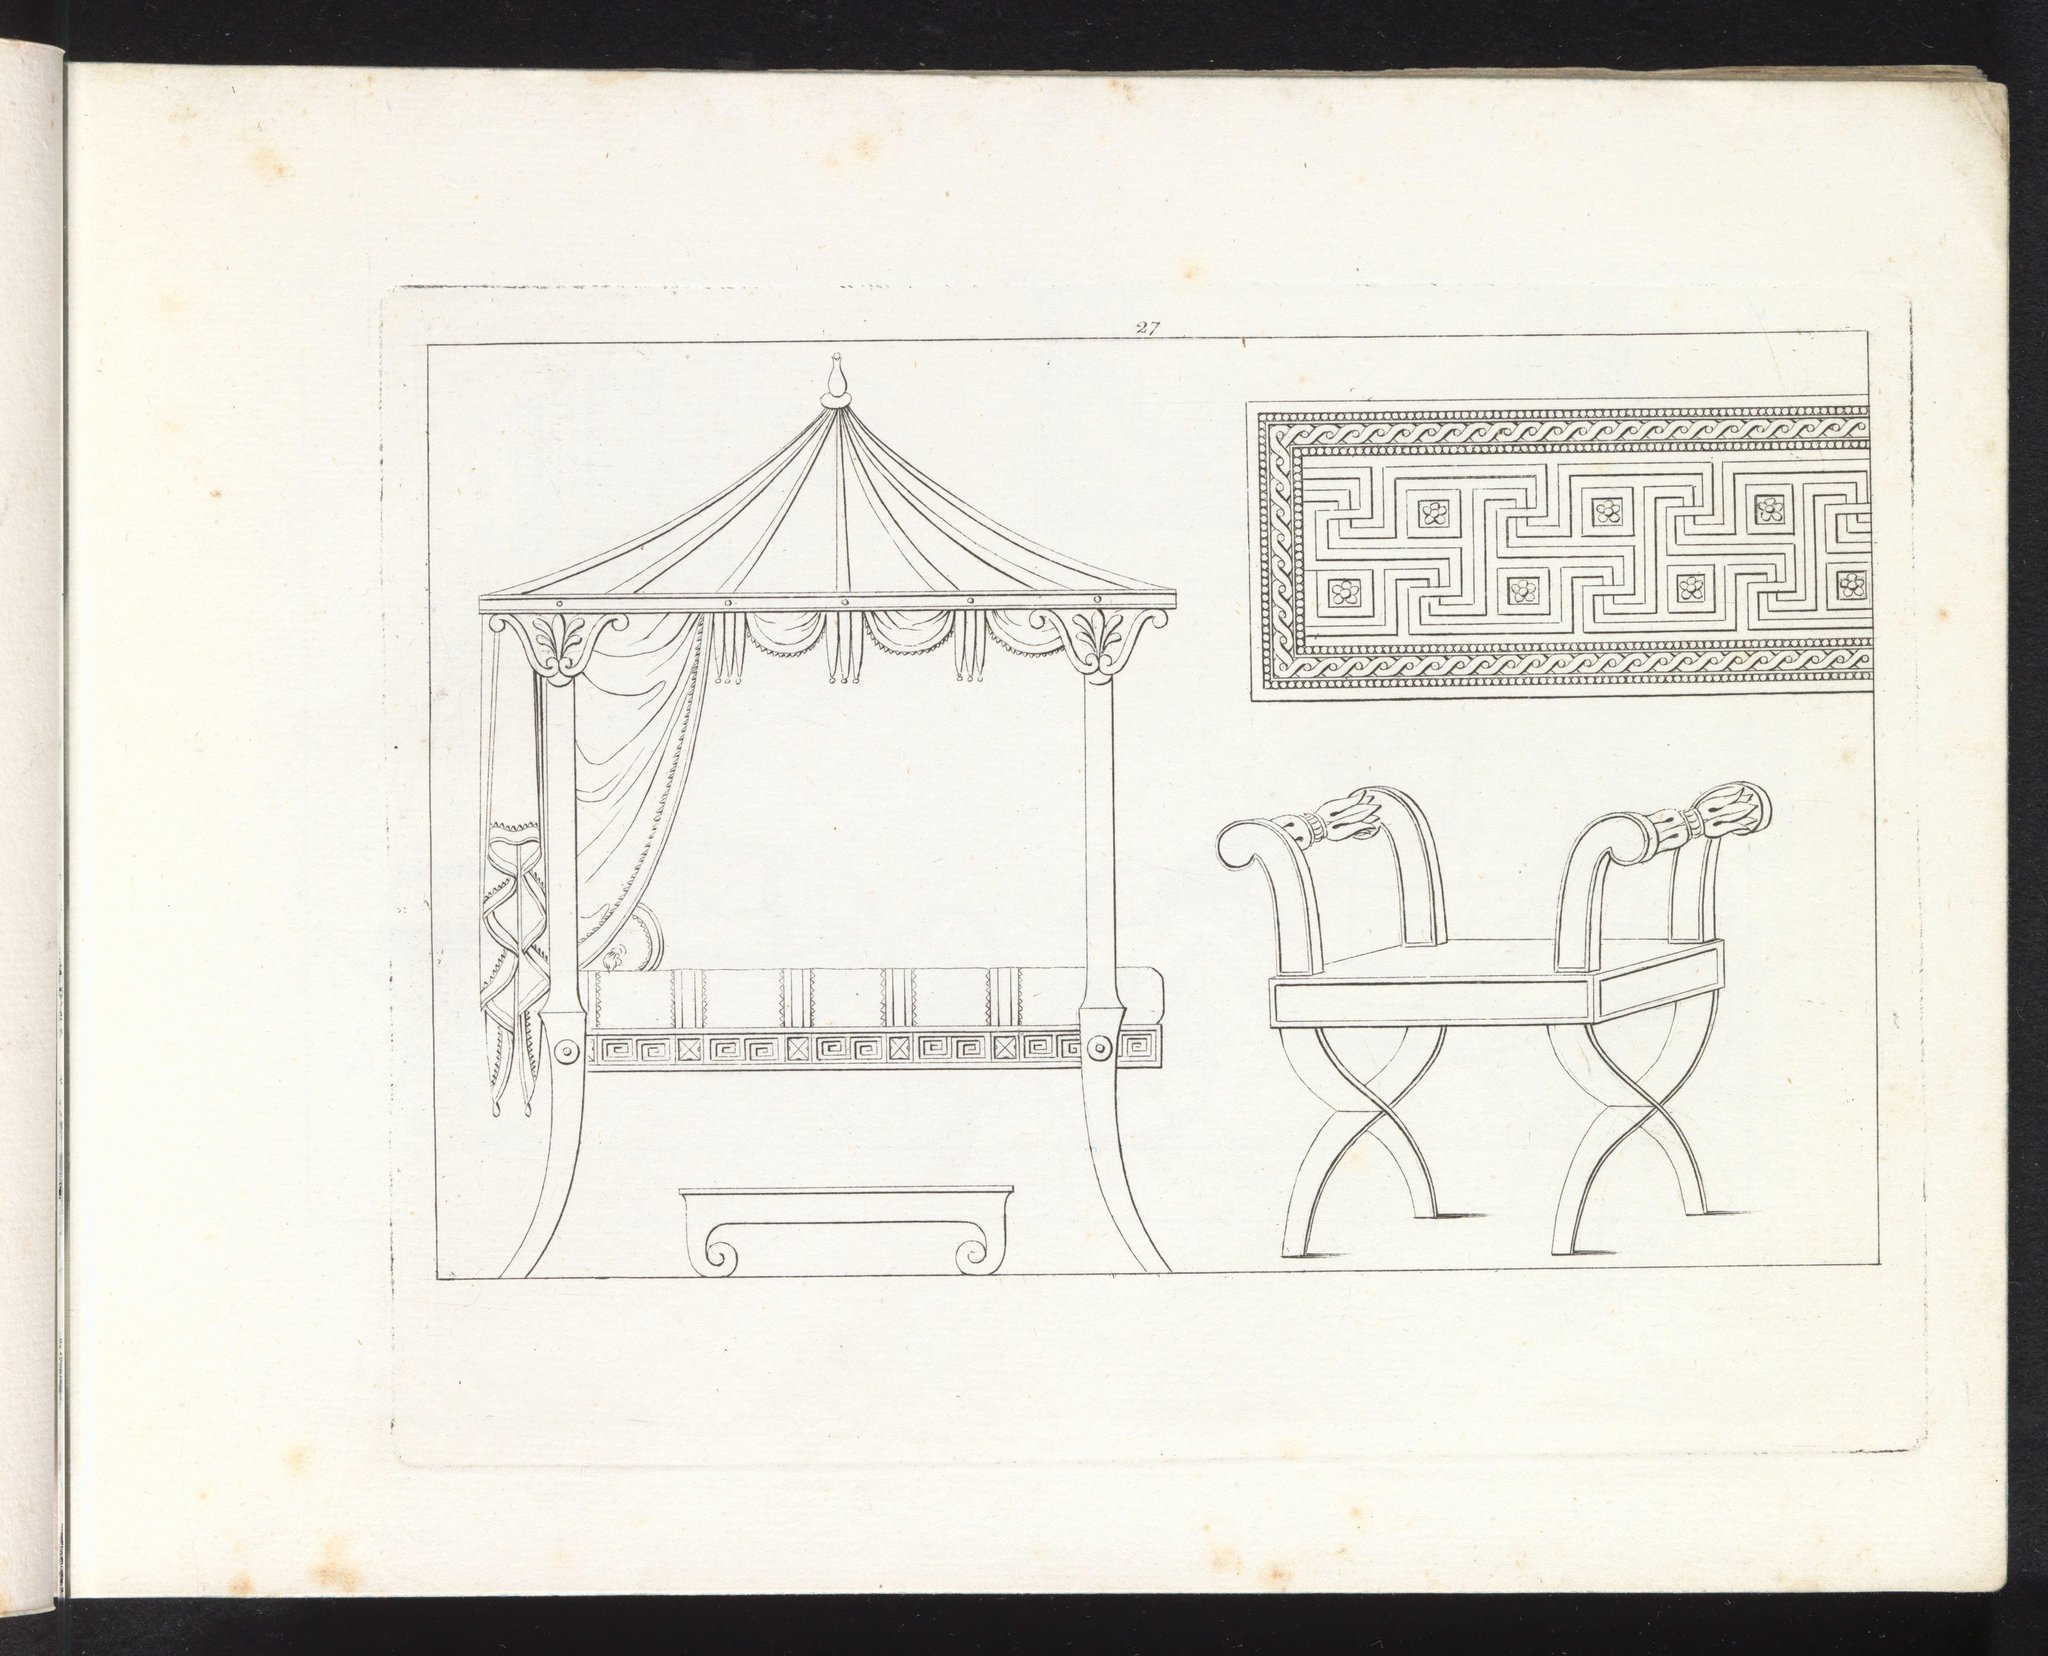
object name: ornament print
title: Ontwerpen voor religieuze en profane voorwerpen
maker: pietro ruga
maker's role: print maker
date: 1817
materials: paper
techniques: etching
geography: italy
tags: bench, ornaments ~ art, bed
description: Prent maakt deel uit van een reeks van 100 prenten (+ titelprent) met ontwerpen voor religieuze en profane voorwerpen.